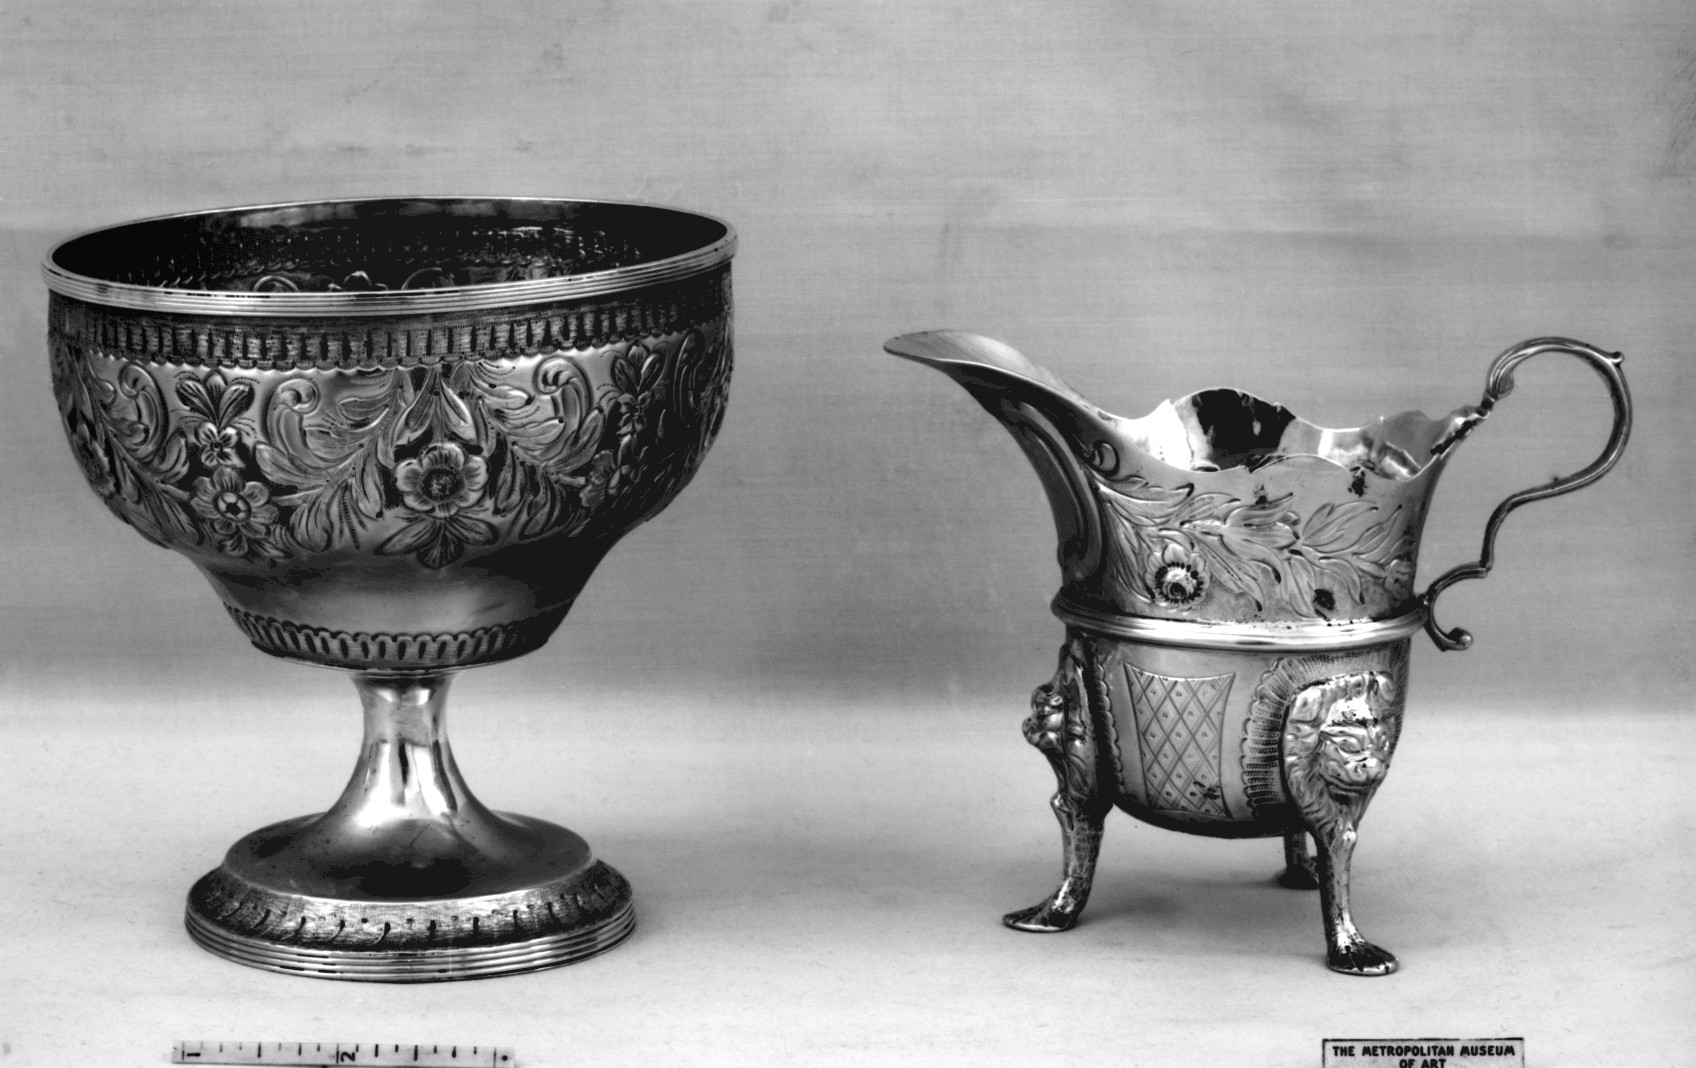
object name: cream jug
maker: william townsend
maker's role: maker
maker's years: 1700-1800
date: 1735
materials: silver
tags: flowers